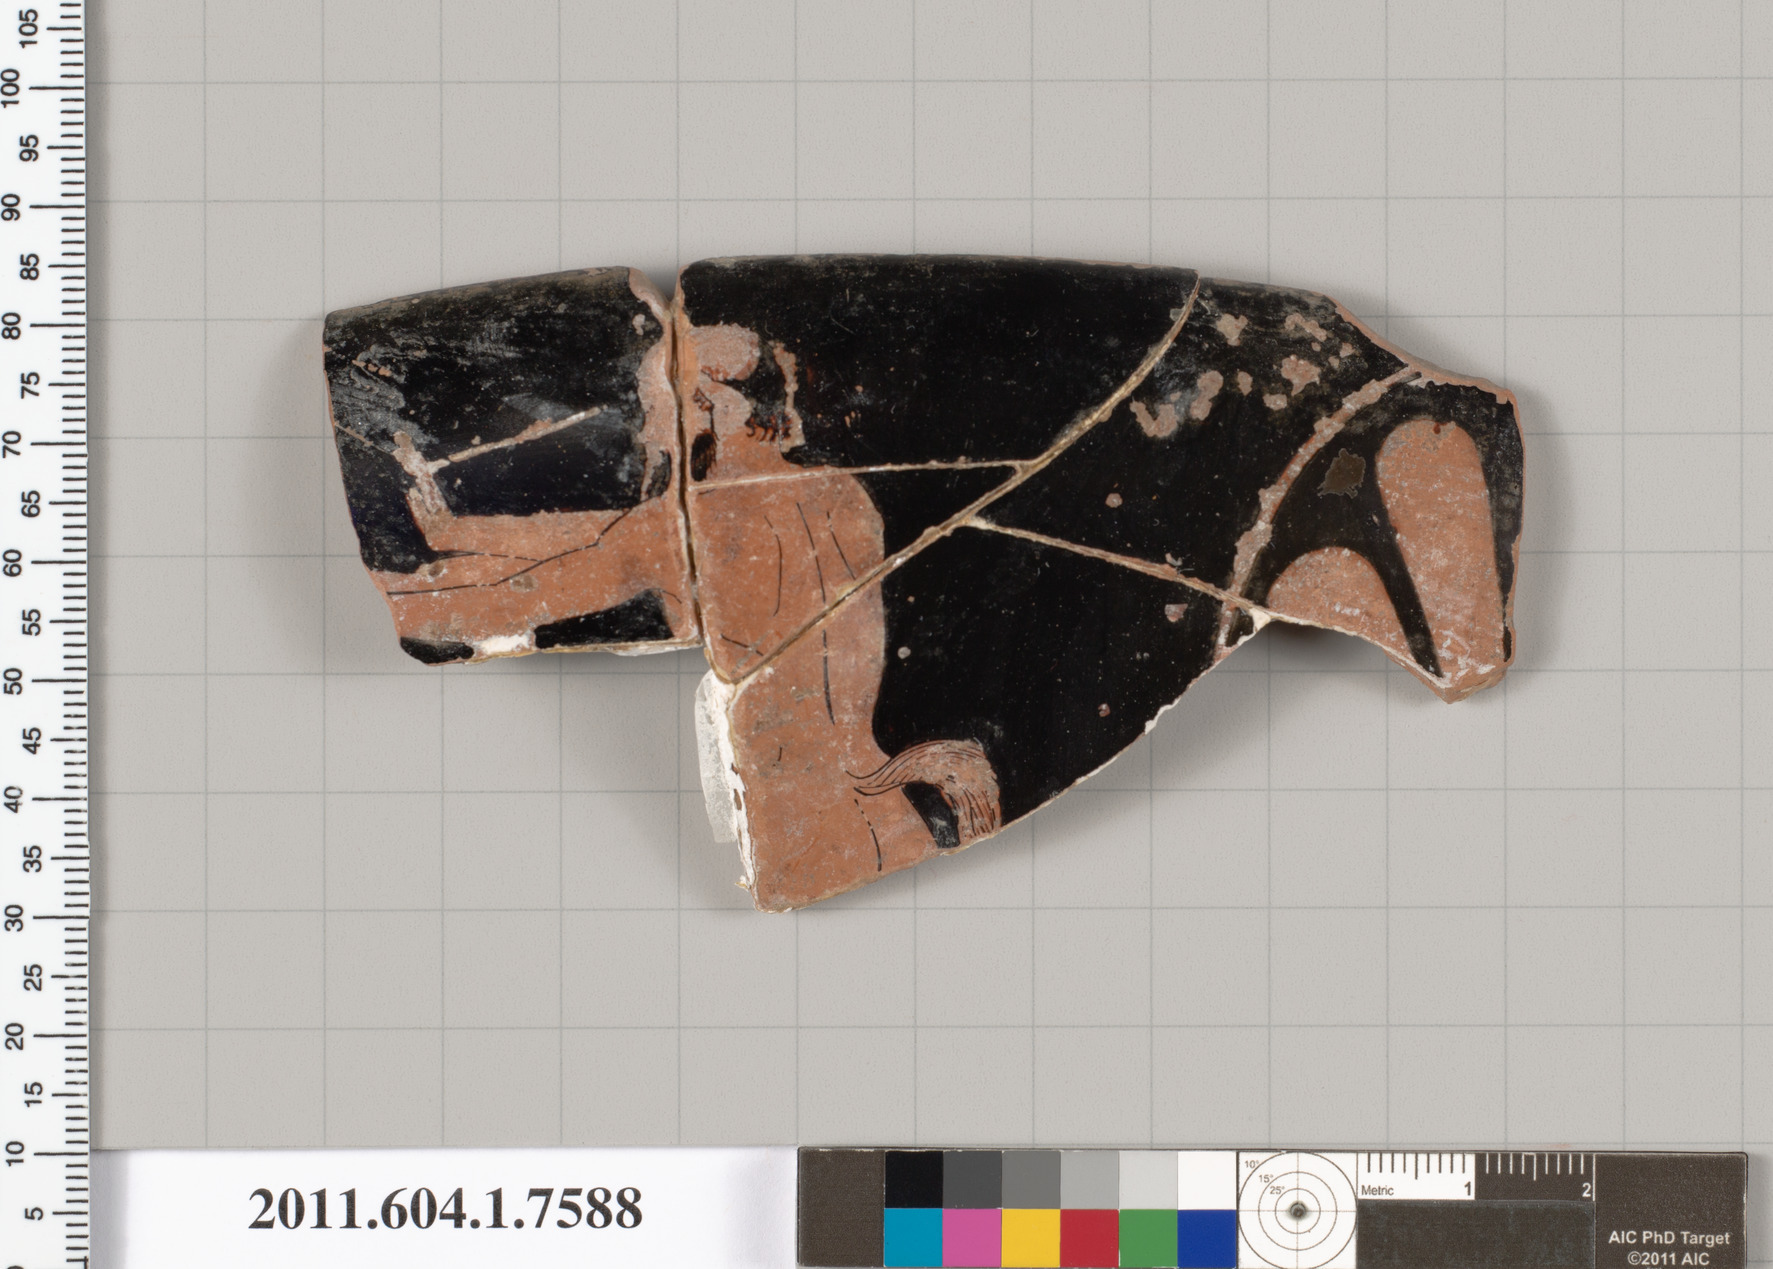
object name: kylix fragment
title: Terracotta rim fragment of a kylix (drinking cup)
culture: greek, attic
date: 460-450 BCE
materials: terracotta